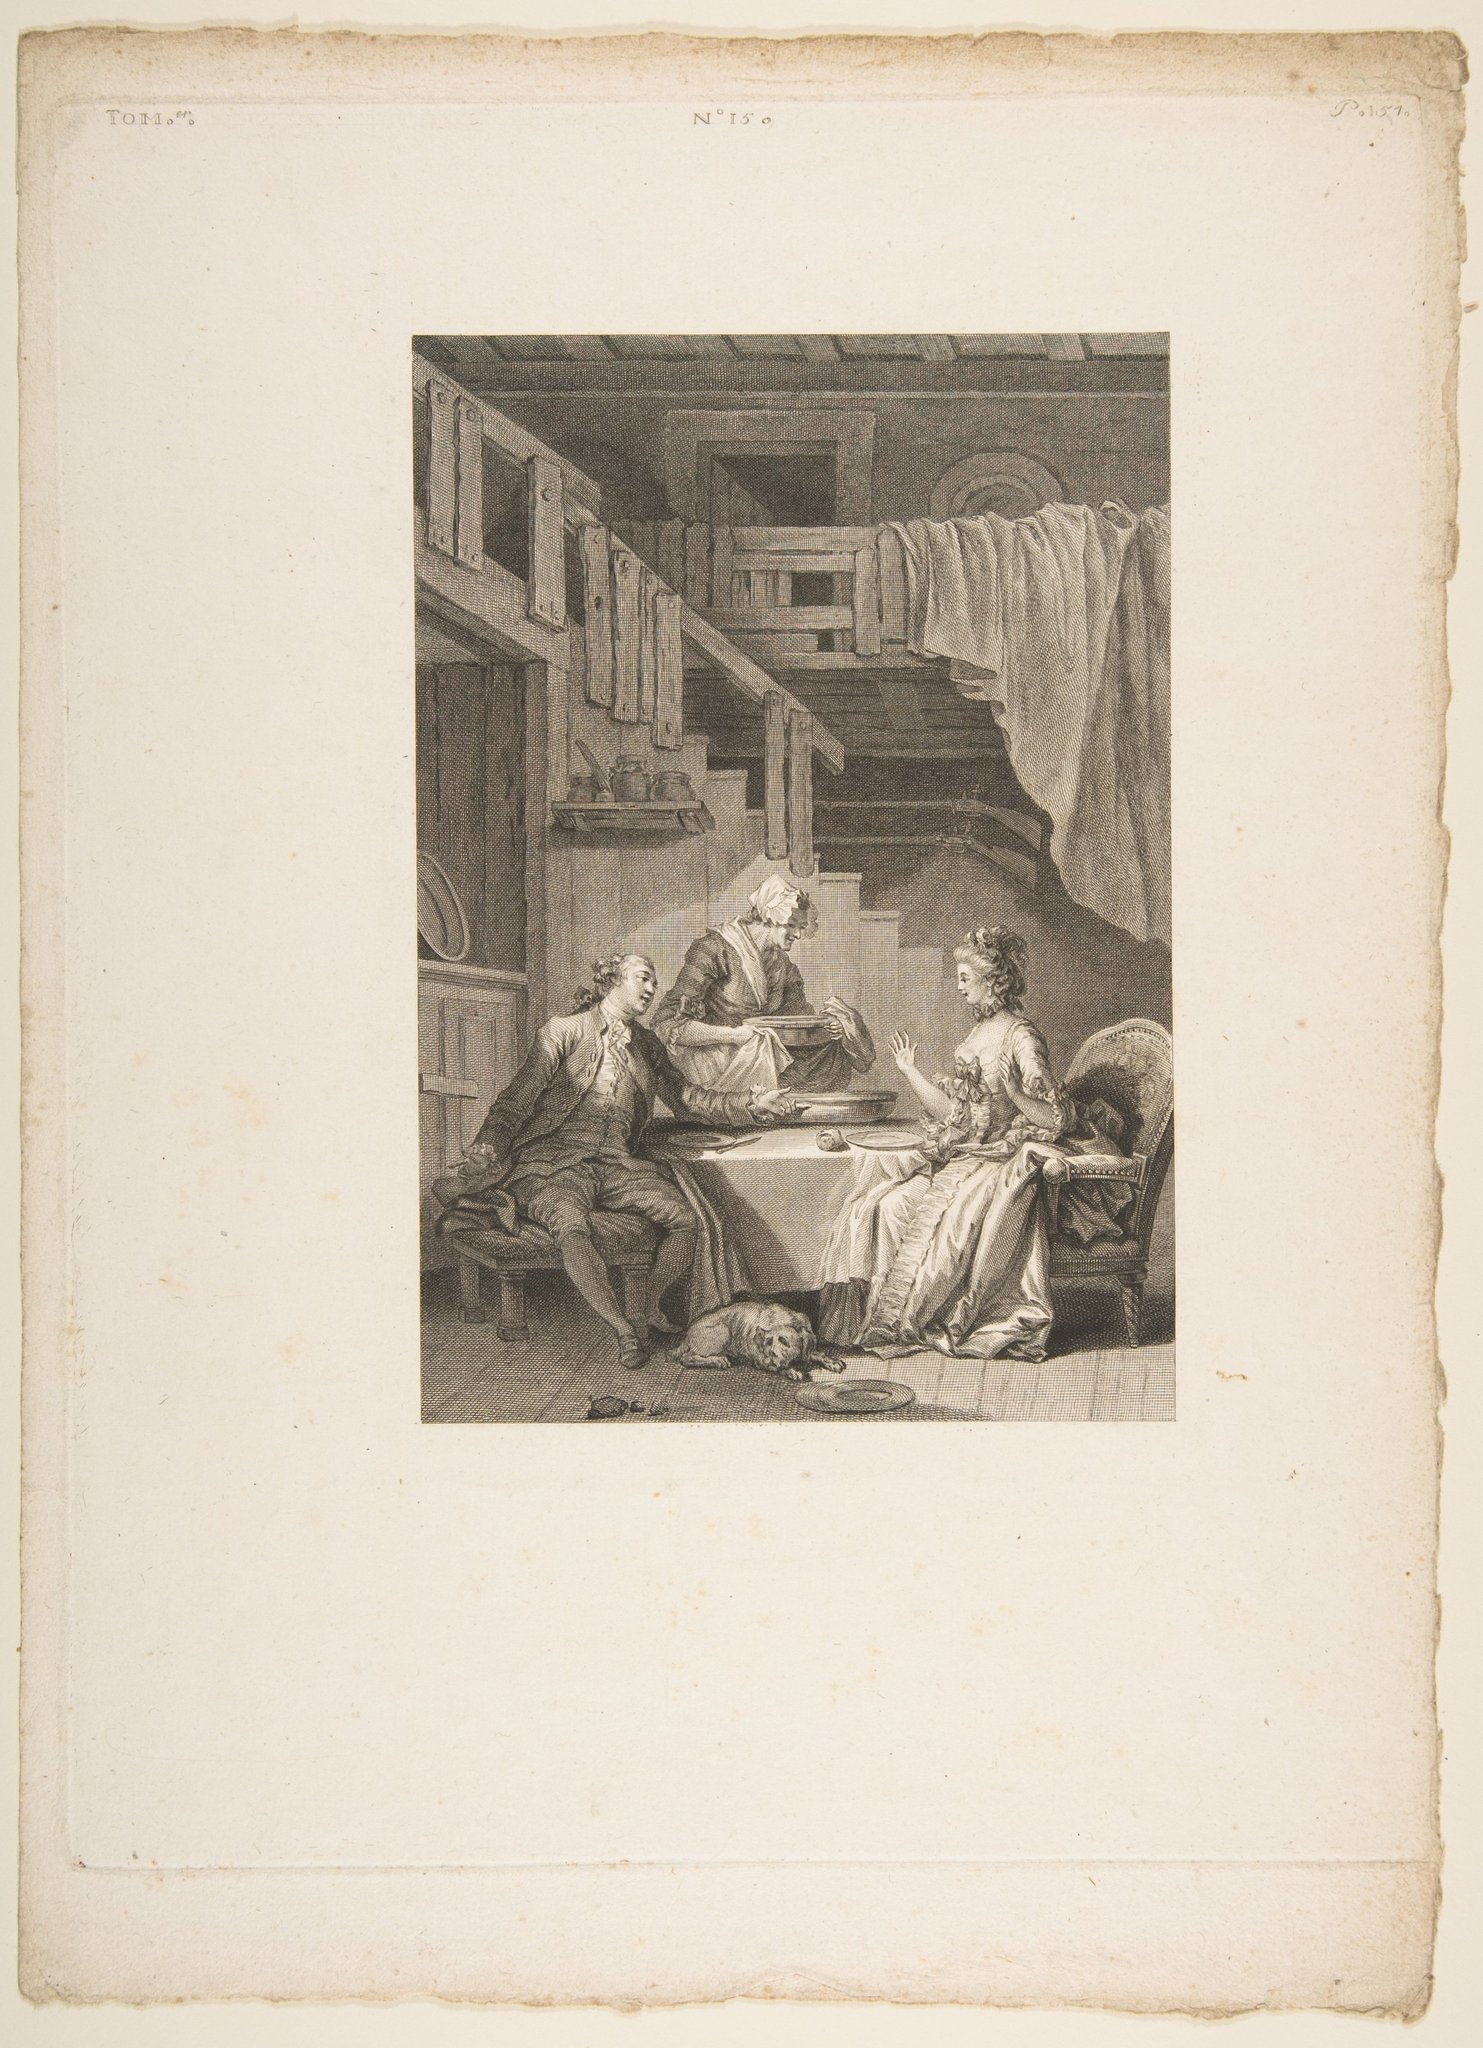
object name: print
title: Le Faucon, La Coupe Enchantee, from "Contes et nouvelles en vers par Jean de La Fontaine. A Paris, de l'imprimerie de P. Didot, l'an III de la République, 1795"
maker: jean-baptiste tilliard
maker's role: artist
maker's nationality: french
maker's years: 1740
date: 1795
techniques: engraving, etching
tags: stairs,dining rooms,men,women,dogs